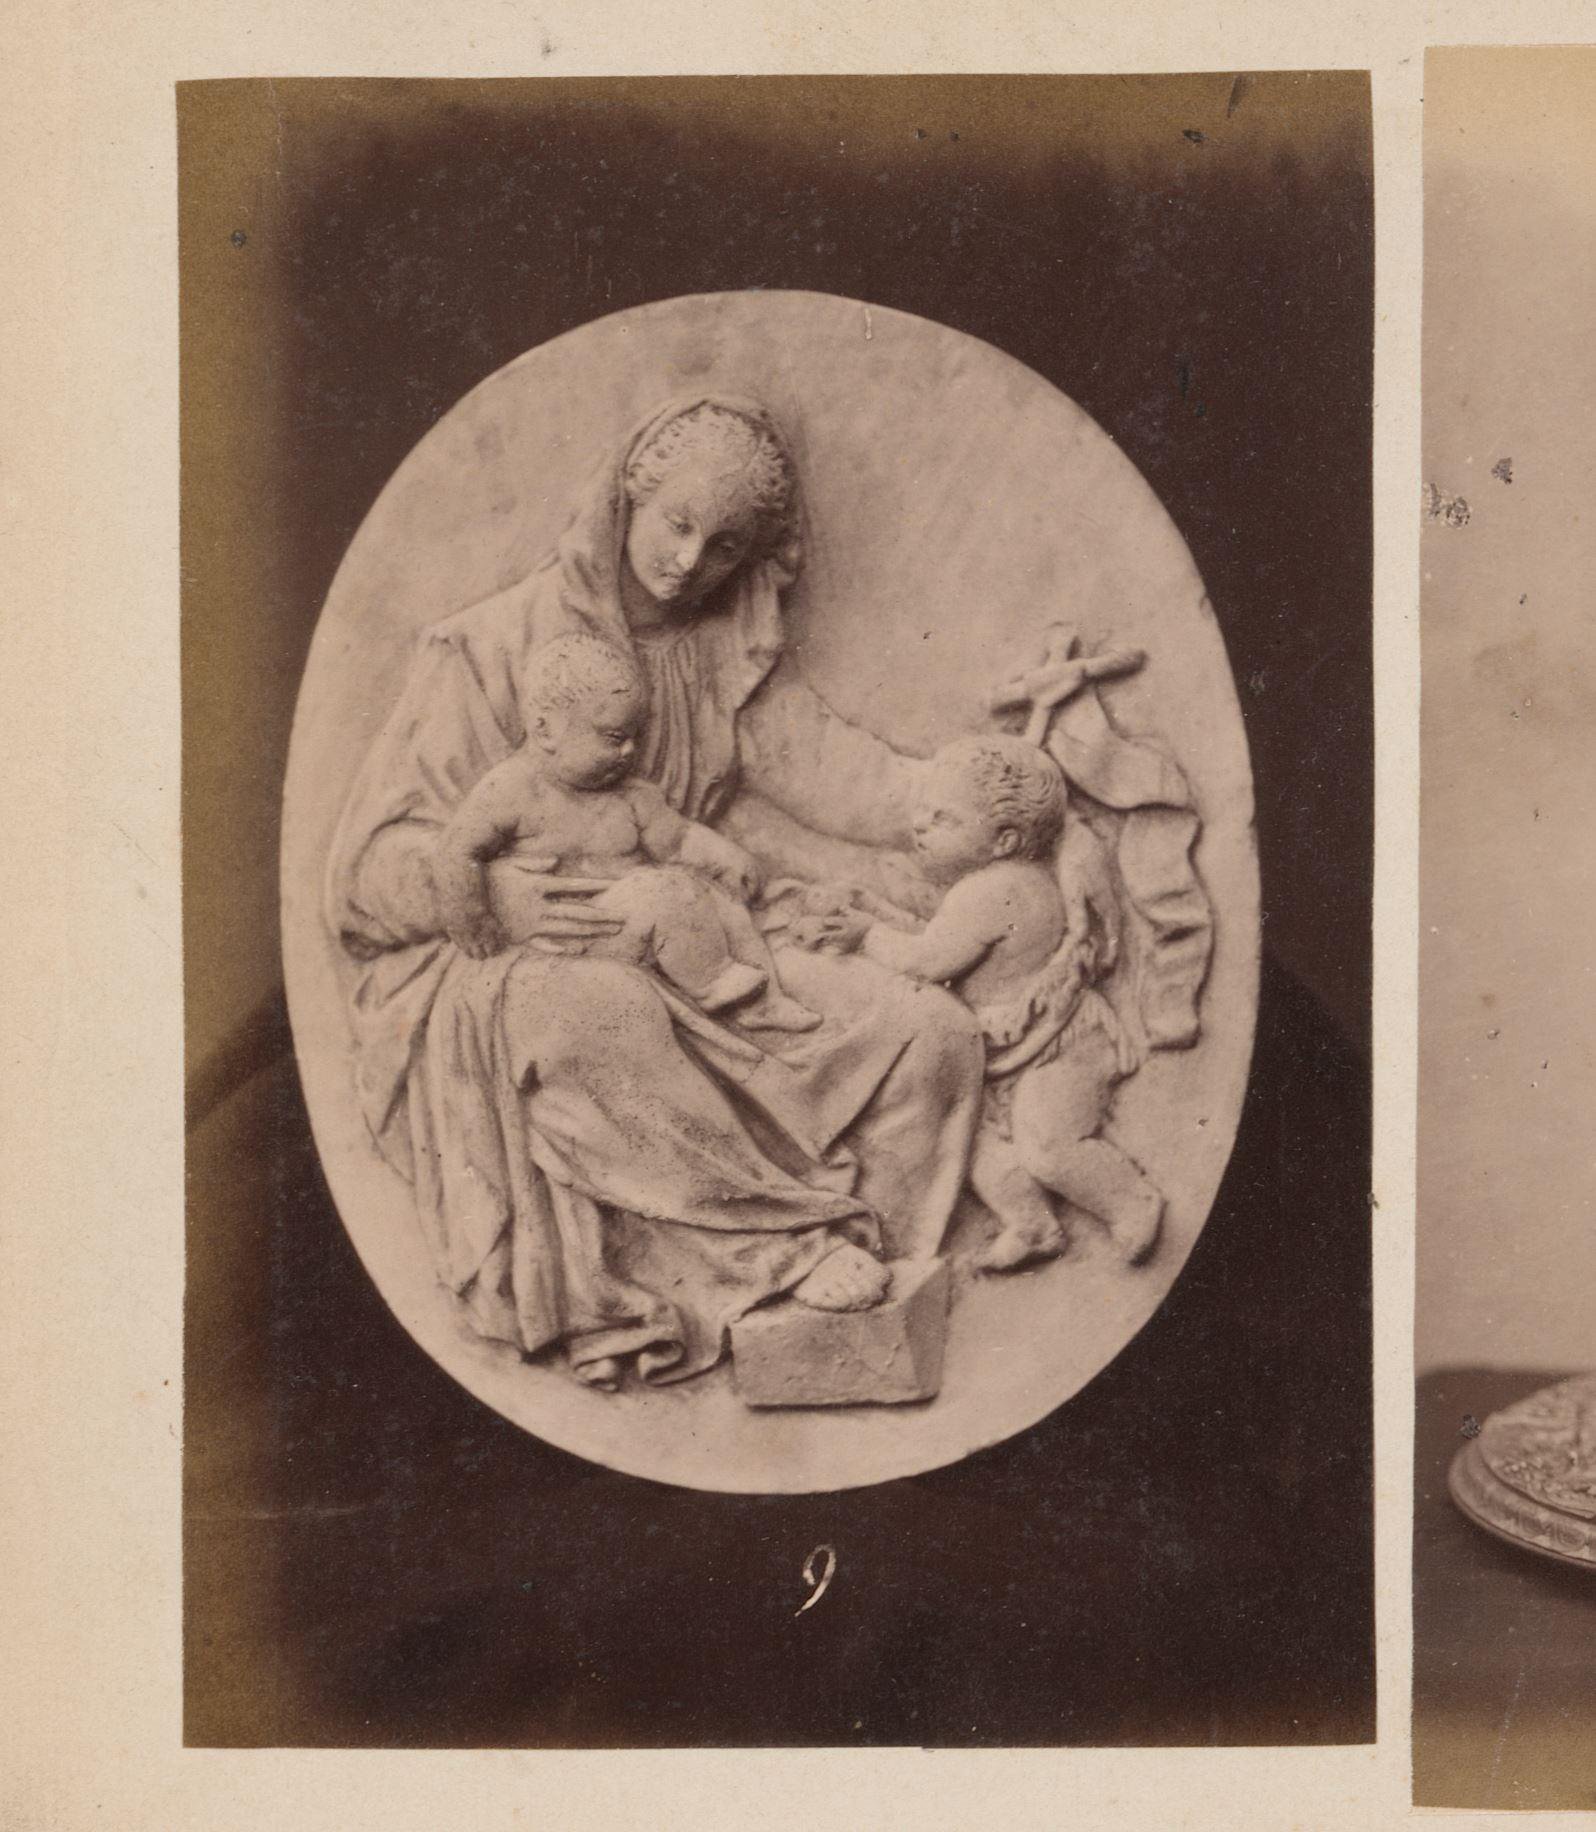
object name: page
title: Bronzen kerkobject, reliëf van Maria met Christus en Johannes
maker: Anonymous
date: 1860-1885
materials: photographic support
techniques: albumen print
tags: representations derived from holy family